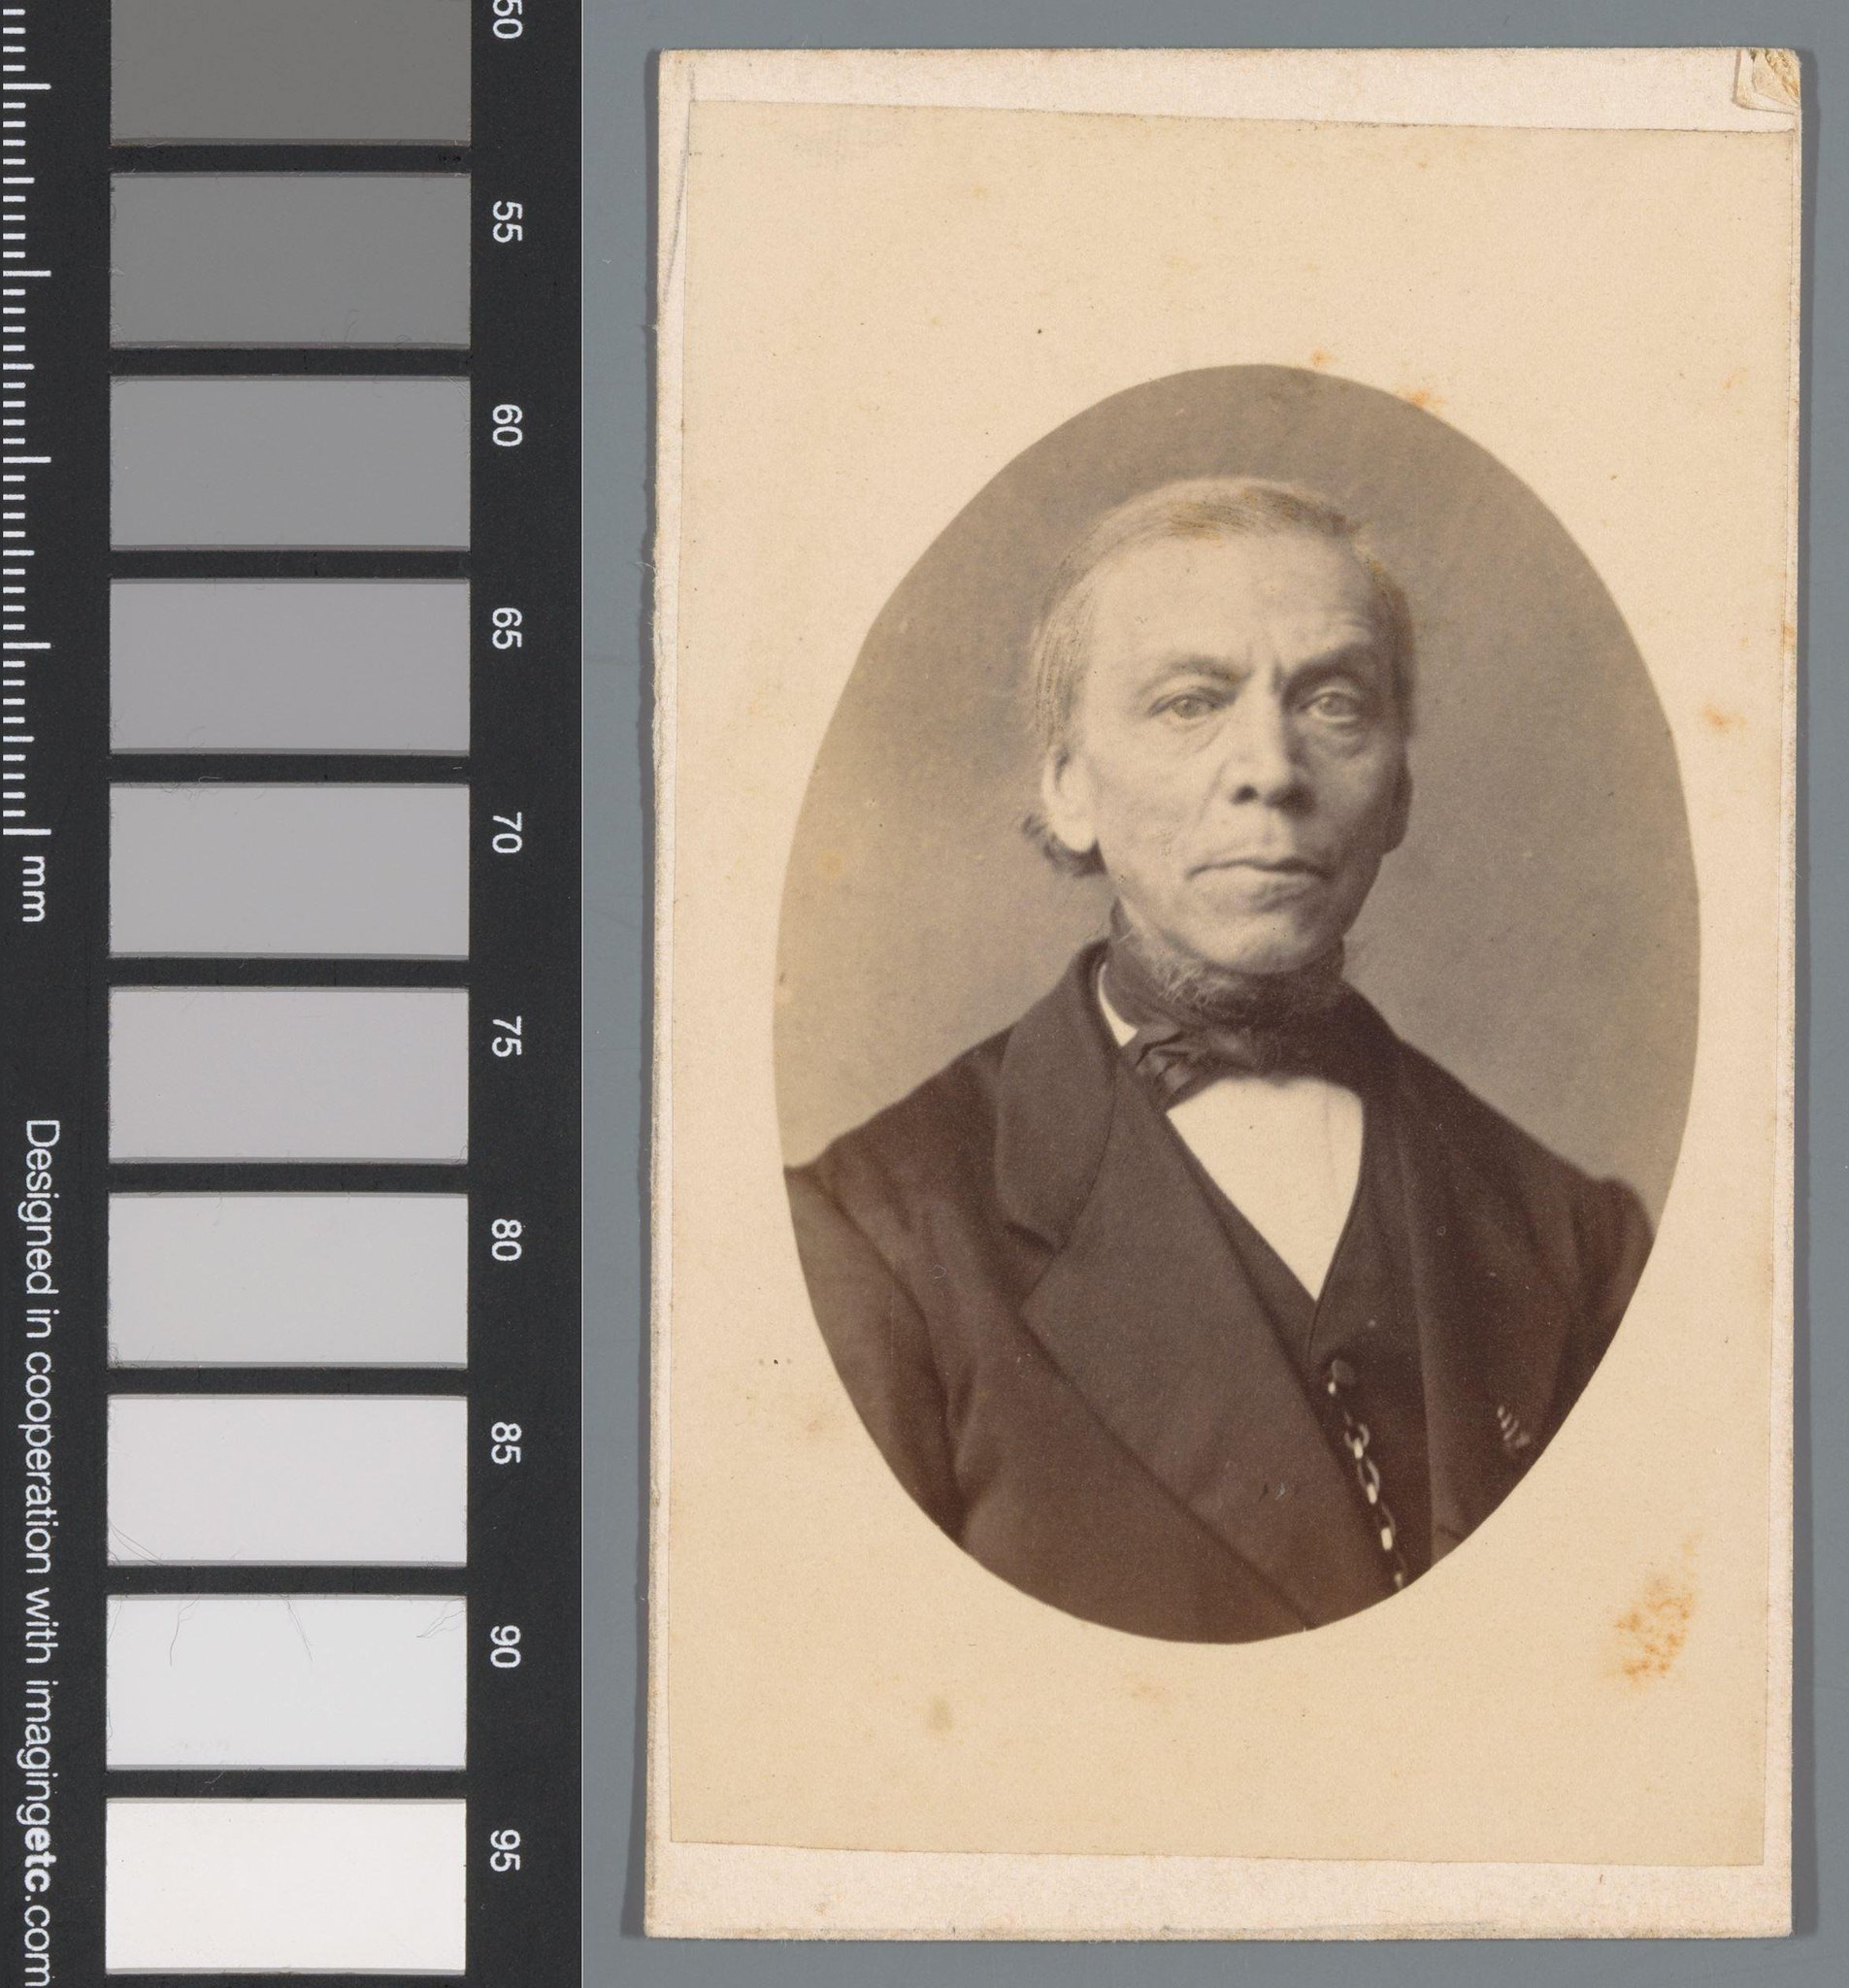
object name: photograph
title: Portret van een onbekende man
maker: Anonymous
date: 1855-1885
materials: cardboard, paper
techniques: albumen print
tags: adult man, historical persons